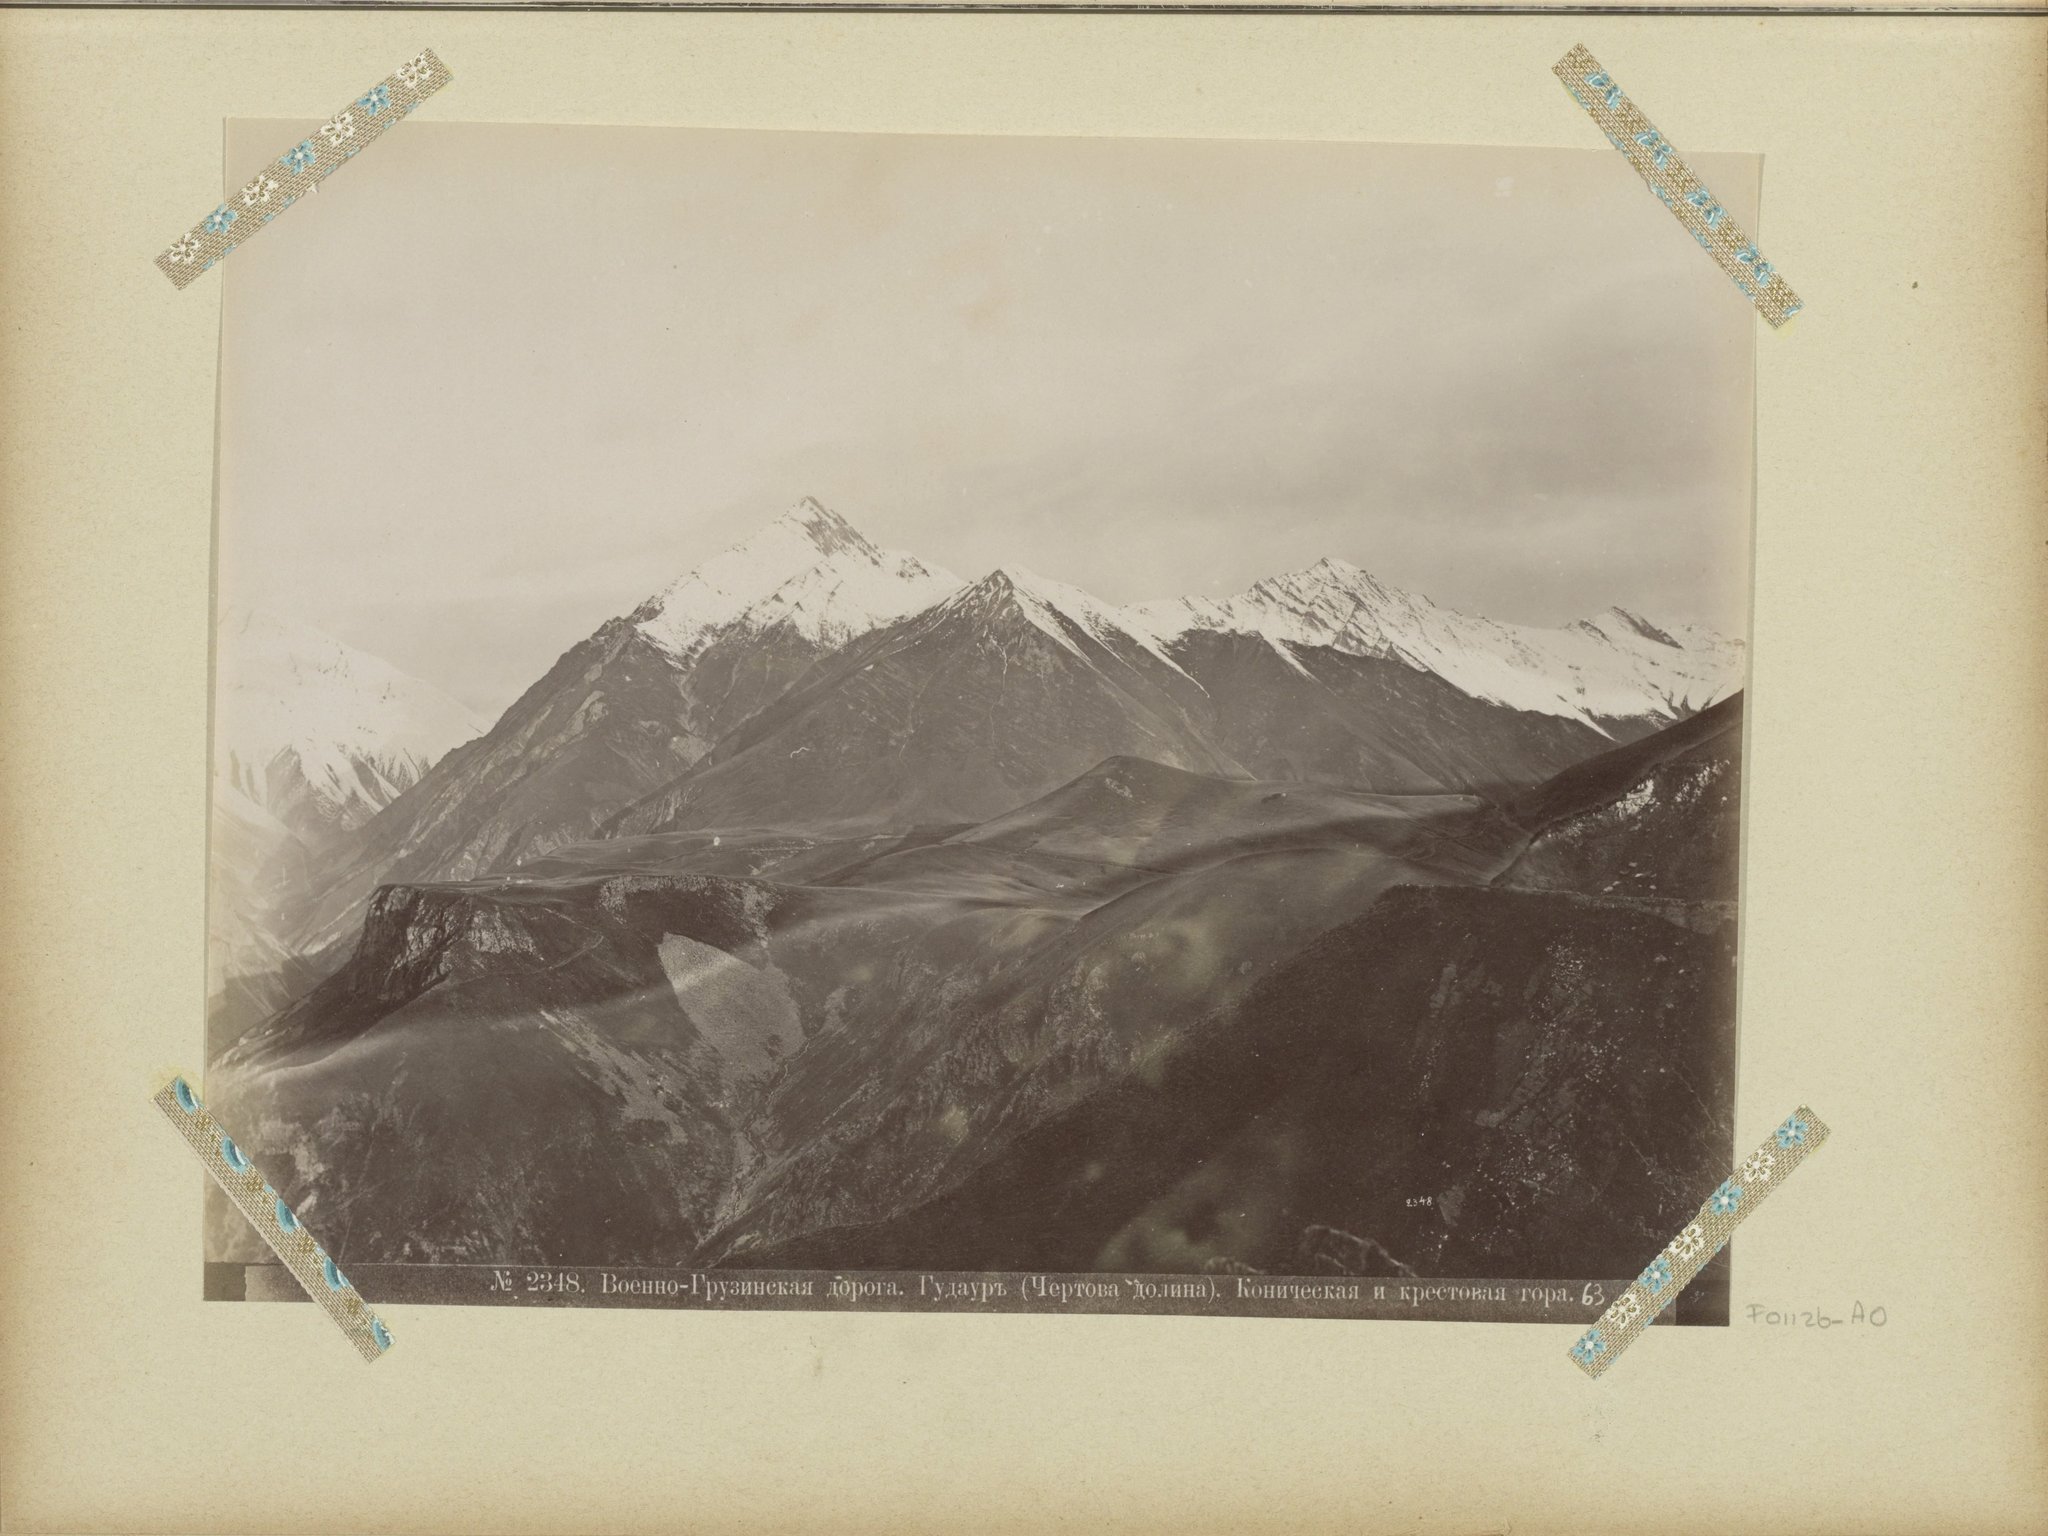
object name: photograph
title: Woenno-Groezinskaja doroga. Goedaoer (Tsjortowa dolina). Konitsjowskaja i krjostowaja gora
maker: dimitri ivanovitch ermakov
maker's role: fotograaf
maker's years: 1845-1916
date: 1890-1900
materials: photographic support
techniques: albumen print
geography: georgia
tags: mountain-range, snow peaks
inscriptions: number: ‘63’, number: ‘2348’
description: Onderdeel van Fotoalbum met opnames van bezienswaardigheden in Georgië, Sint-Petersburg en Moskou.